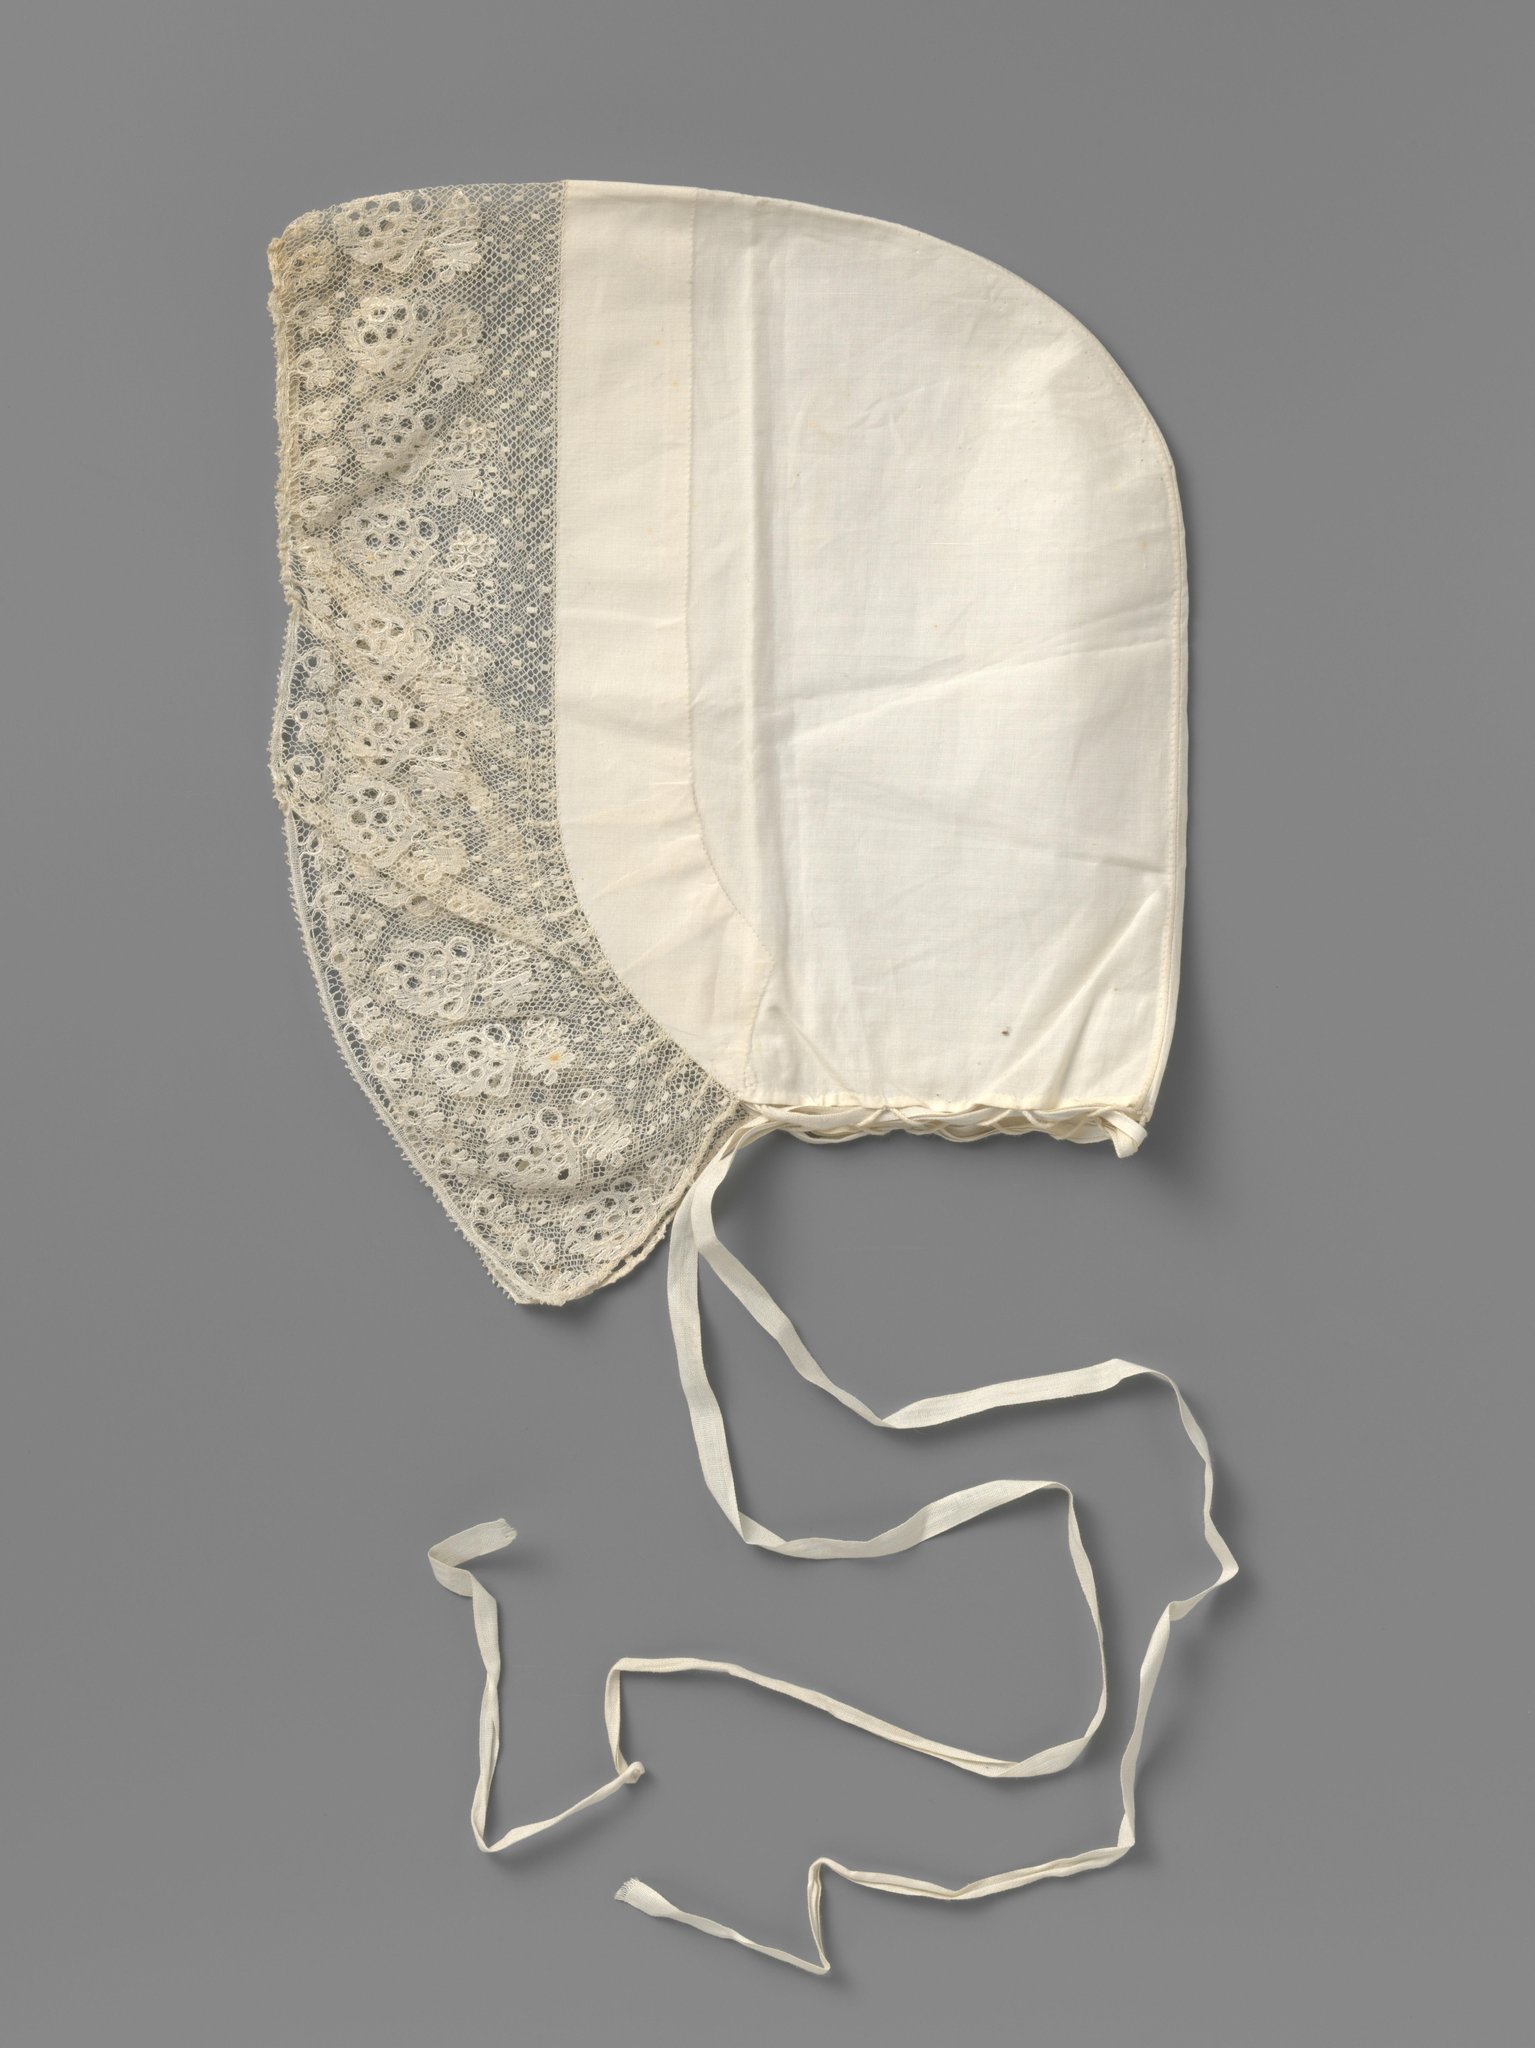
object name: cap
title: Friese muts met strook kloskant met frambozen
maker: Anonymous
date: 1900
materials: cotton, linen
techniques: lace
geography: netherlands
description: Friese muts, aan de voorzijde afgezet met een strook naturelkleurig kloskant: Rijselse kant. Strook met een lopend patroon van hangende, eenzijdig schuingerichte frambozen, die zich aftekenen tegen een met moesjes bezaaide achtergrond van mazen.